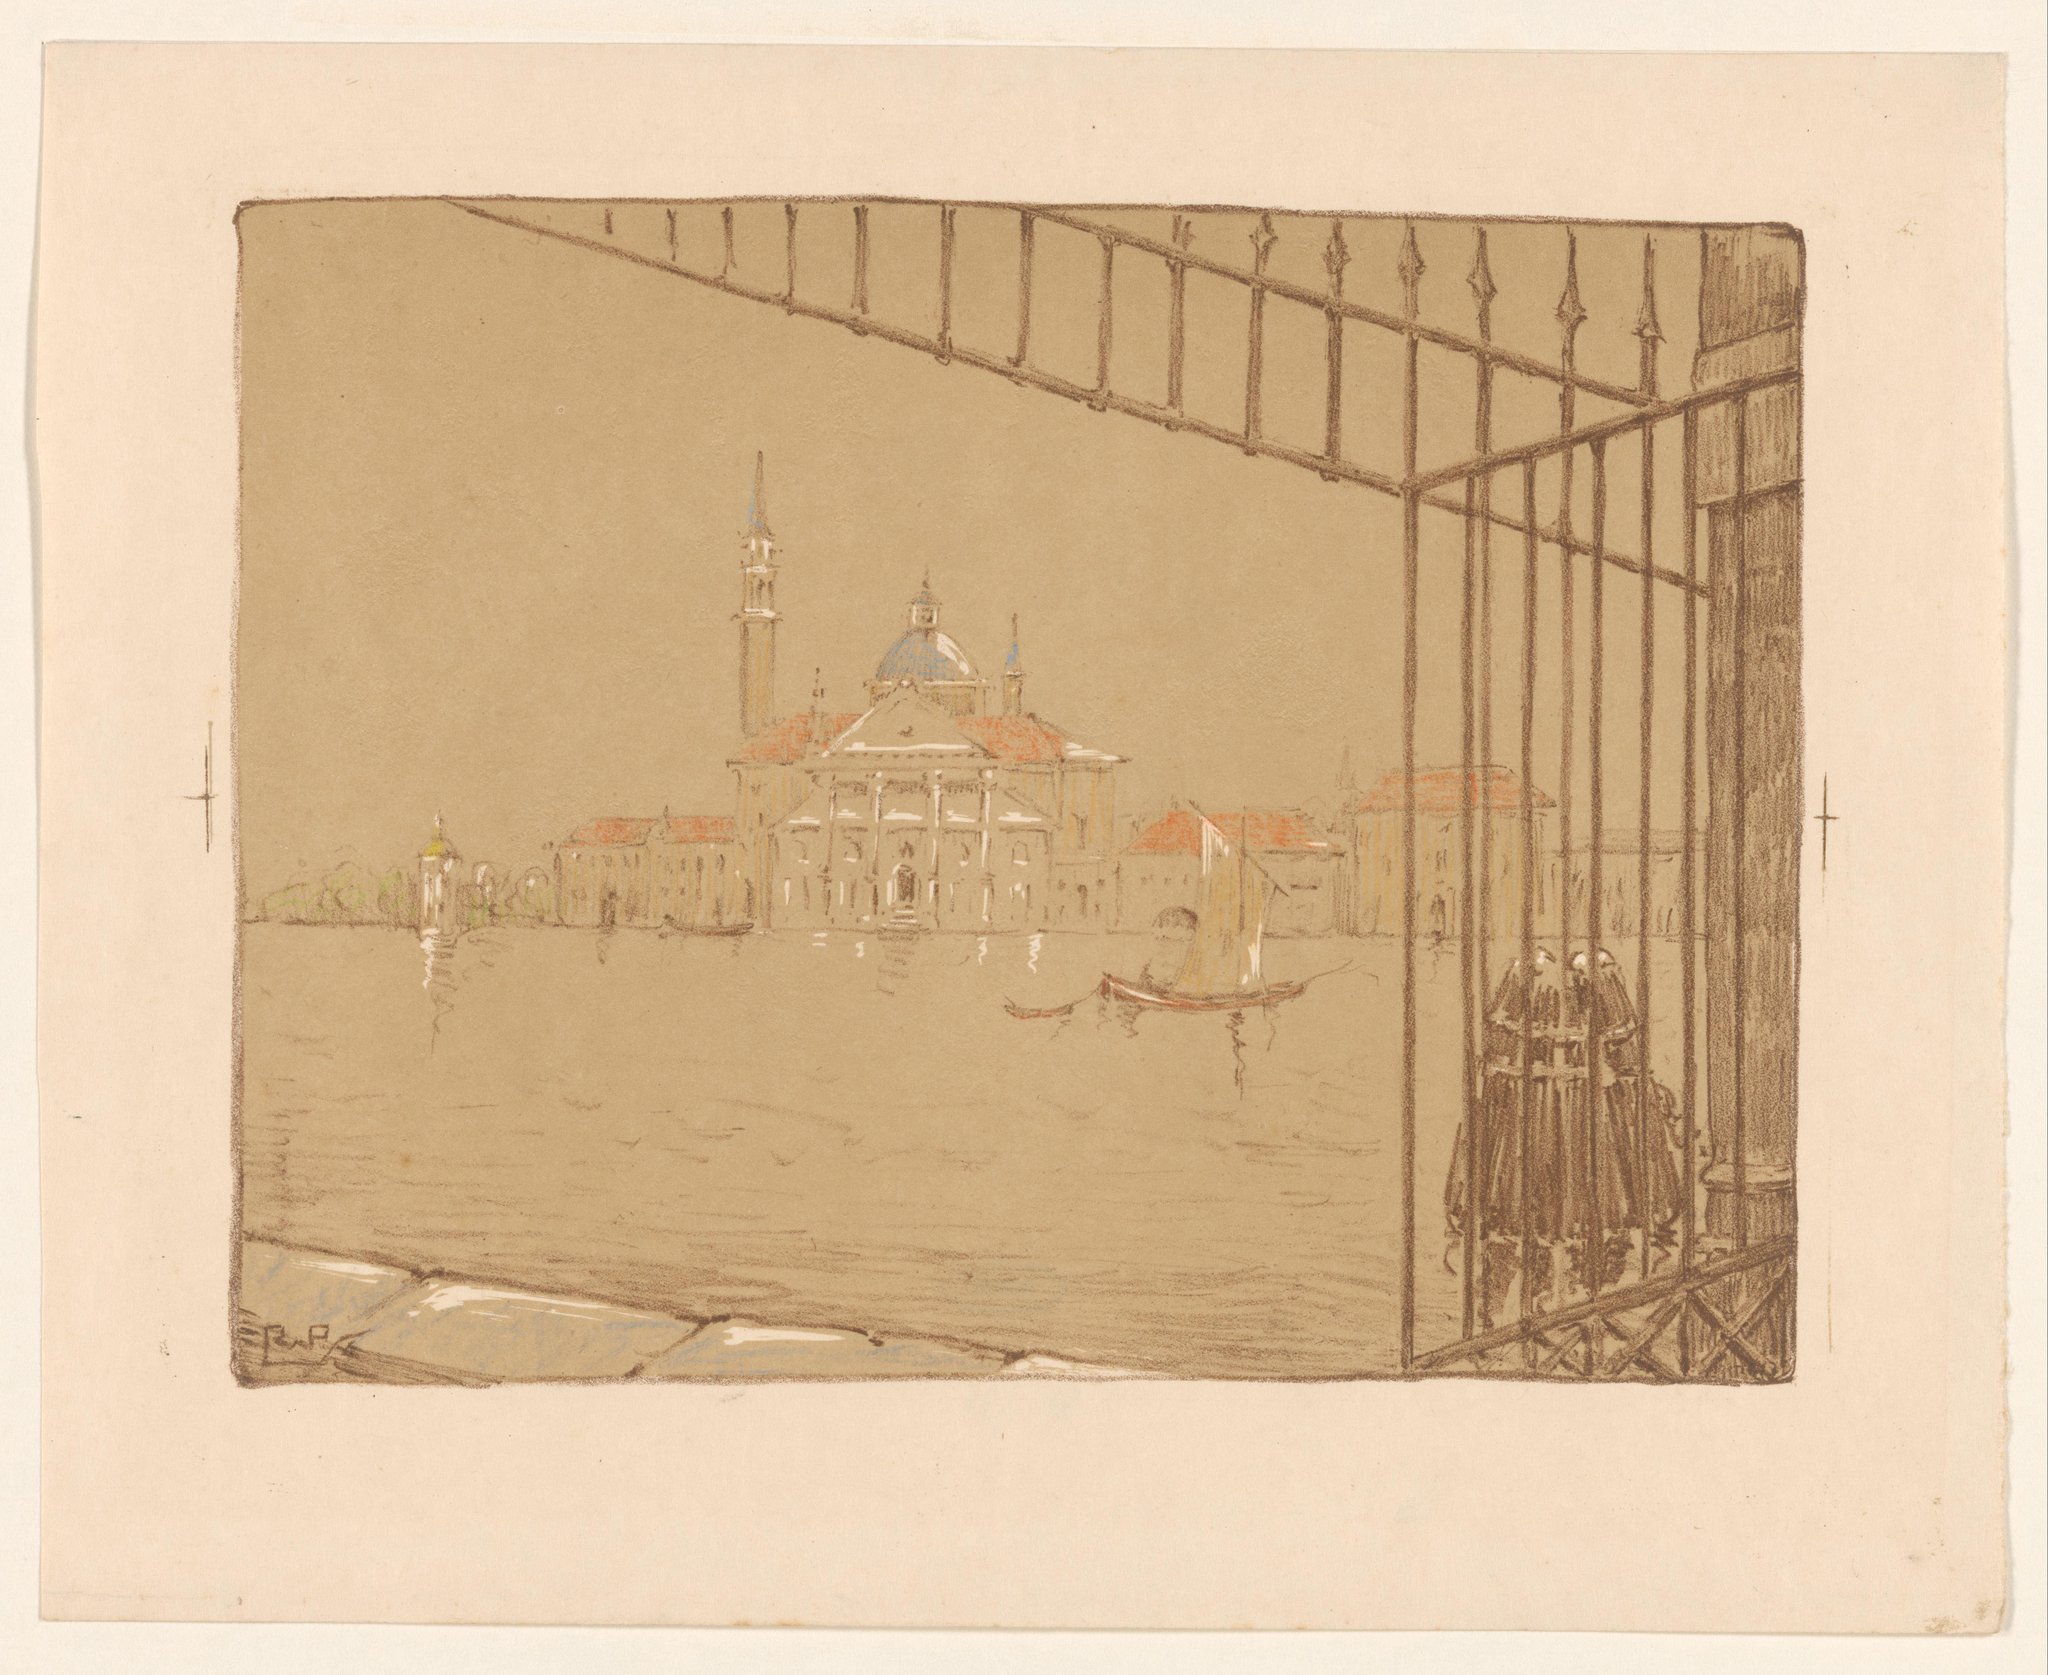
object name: print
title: Gezicht op Venetië met de Chiesa di San Giorgio Maggiore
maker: reinier willem petrus de vries (1874-1953)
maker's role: draughtsman, print maker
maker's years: 1874-1953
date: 1884-1952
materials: paper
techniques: hand coloring, lithograph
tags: church (exterior), canals, waters (in city)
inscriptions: collector's mark: Lugt 2228